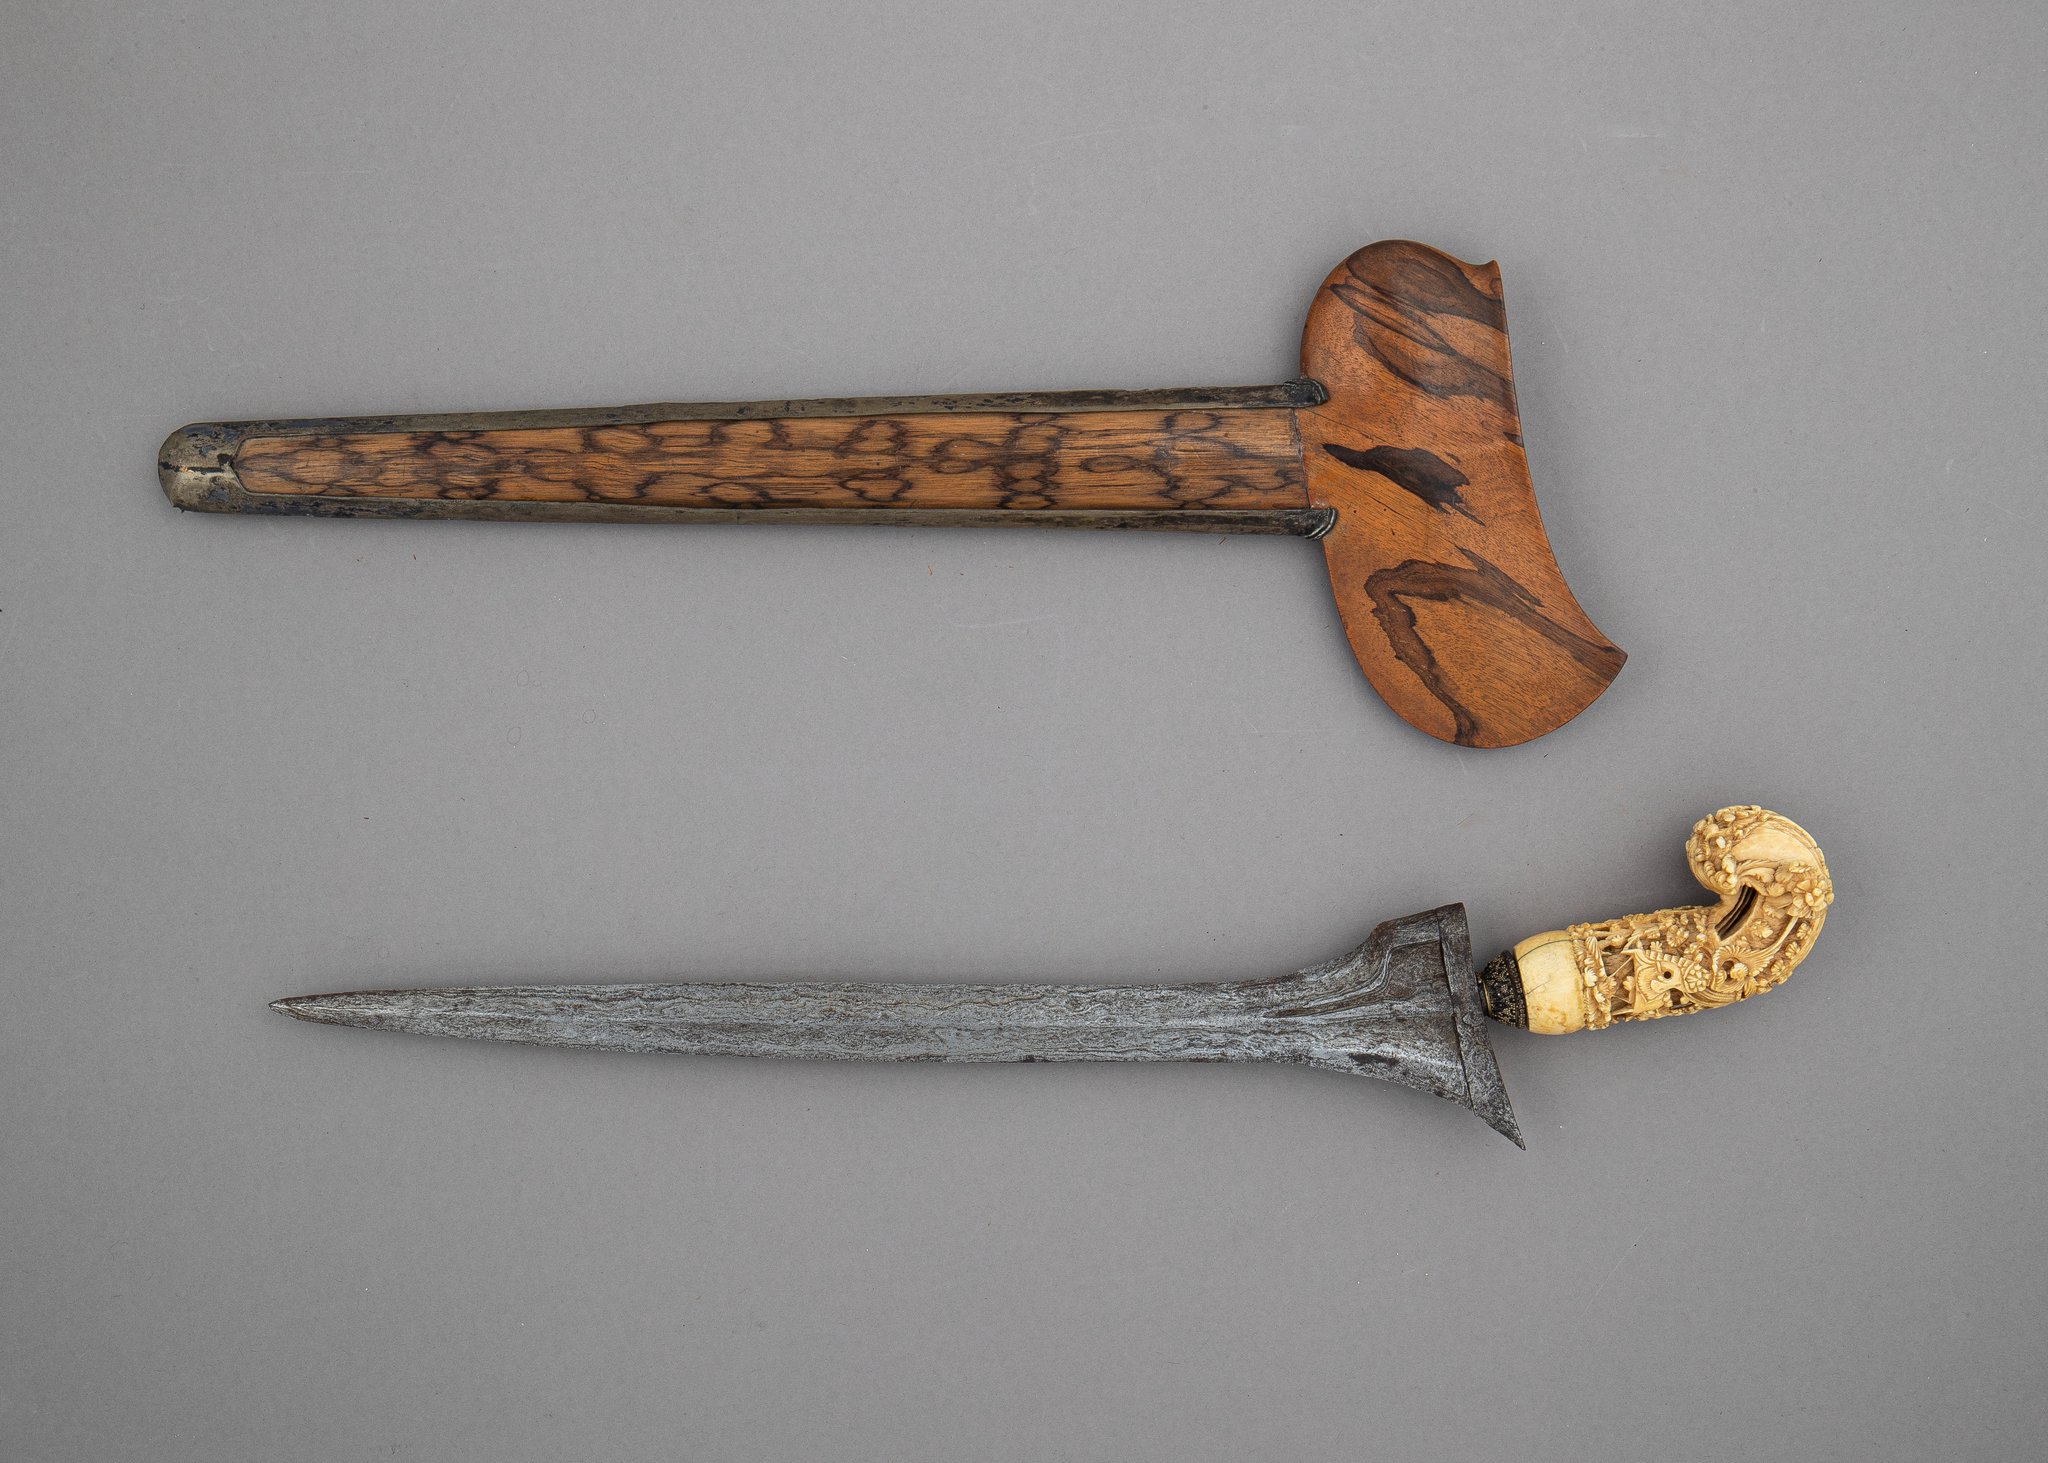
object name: kris with sheath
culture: madurese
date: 1701-1900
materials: brass, ivory, silver, steel, wood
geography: indonesia